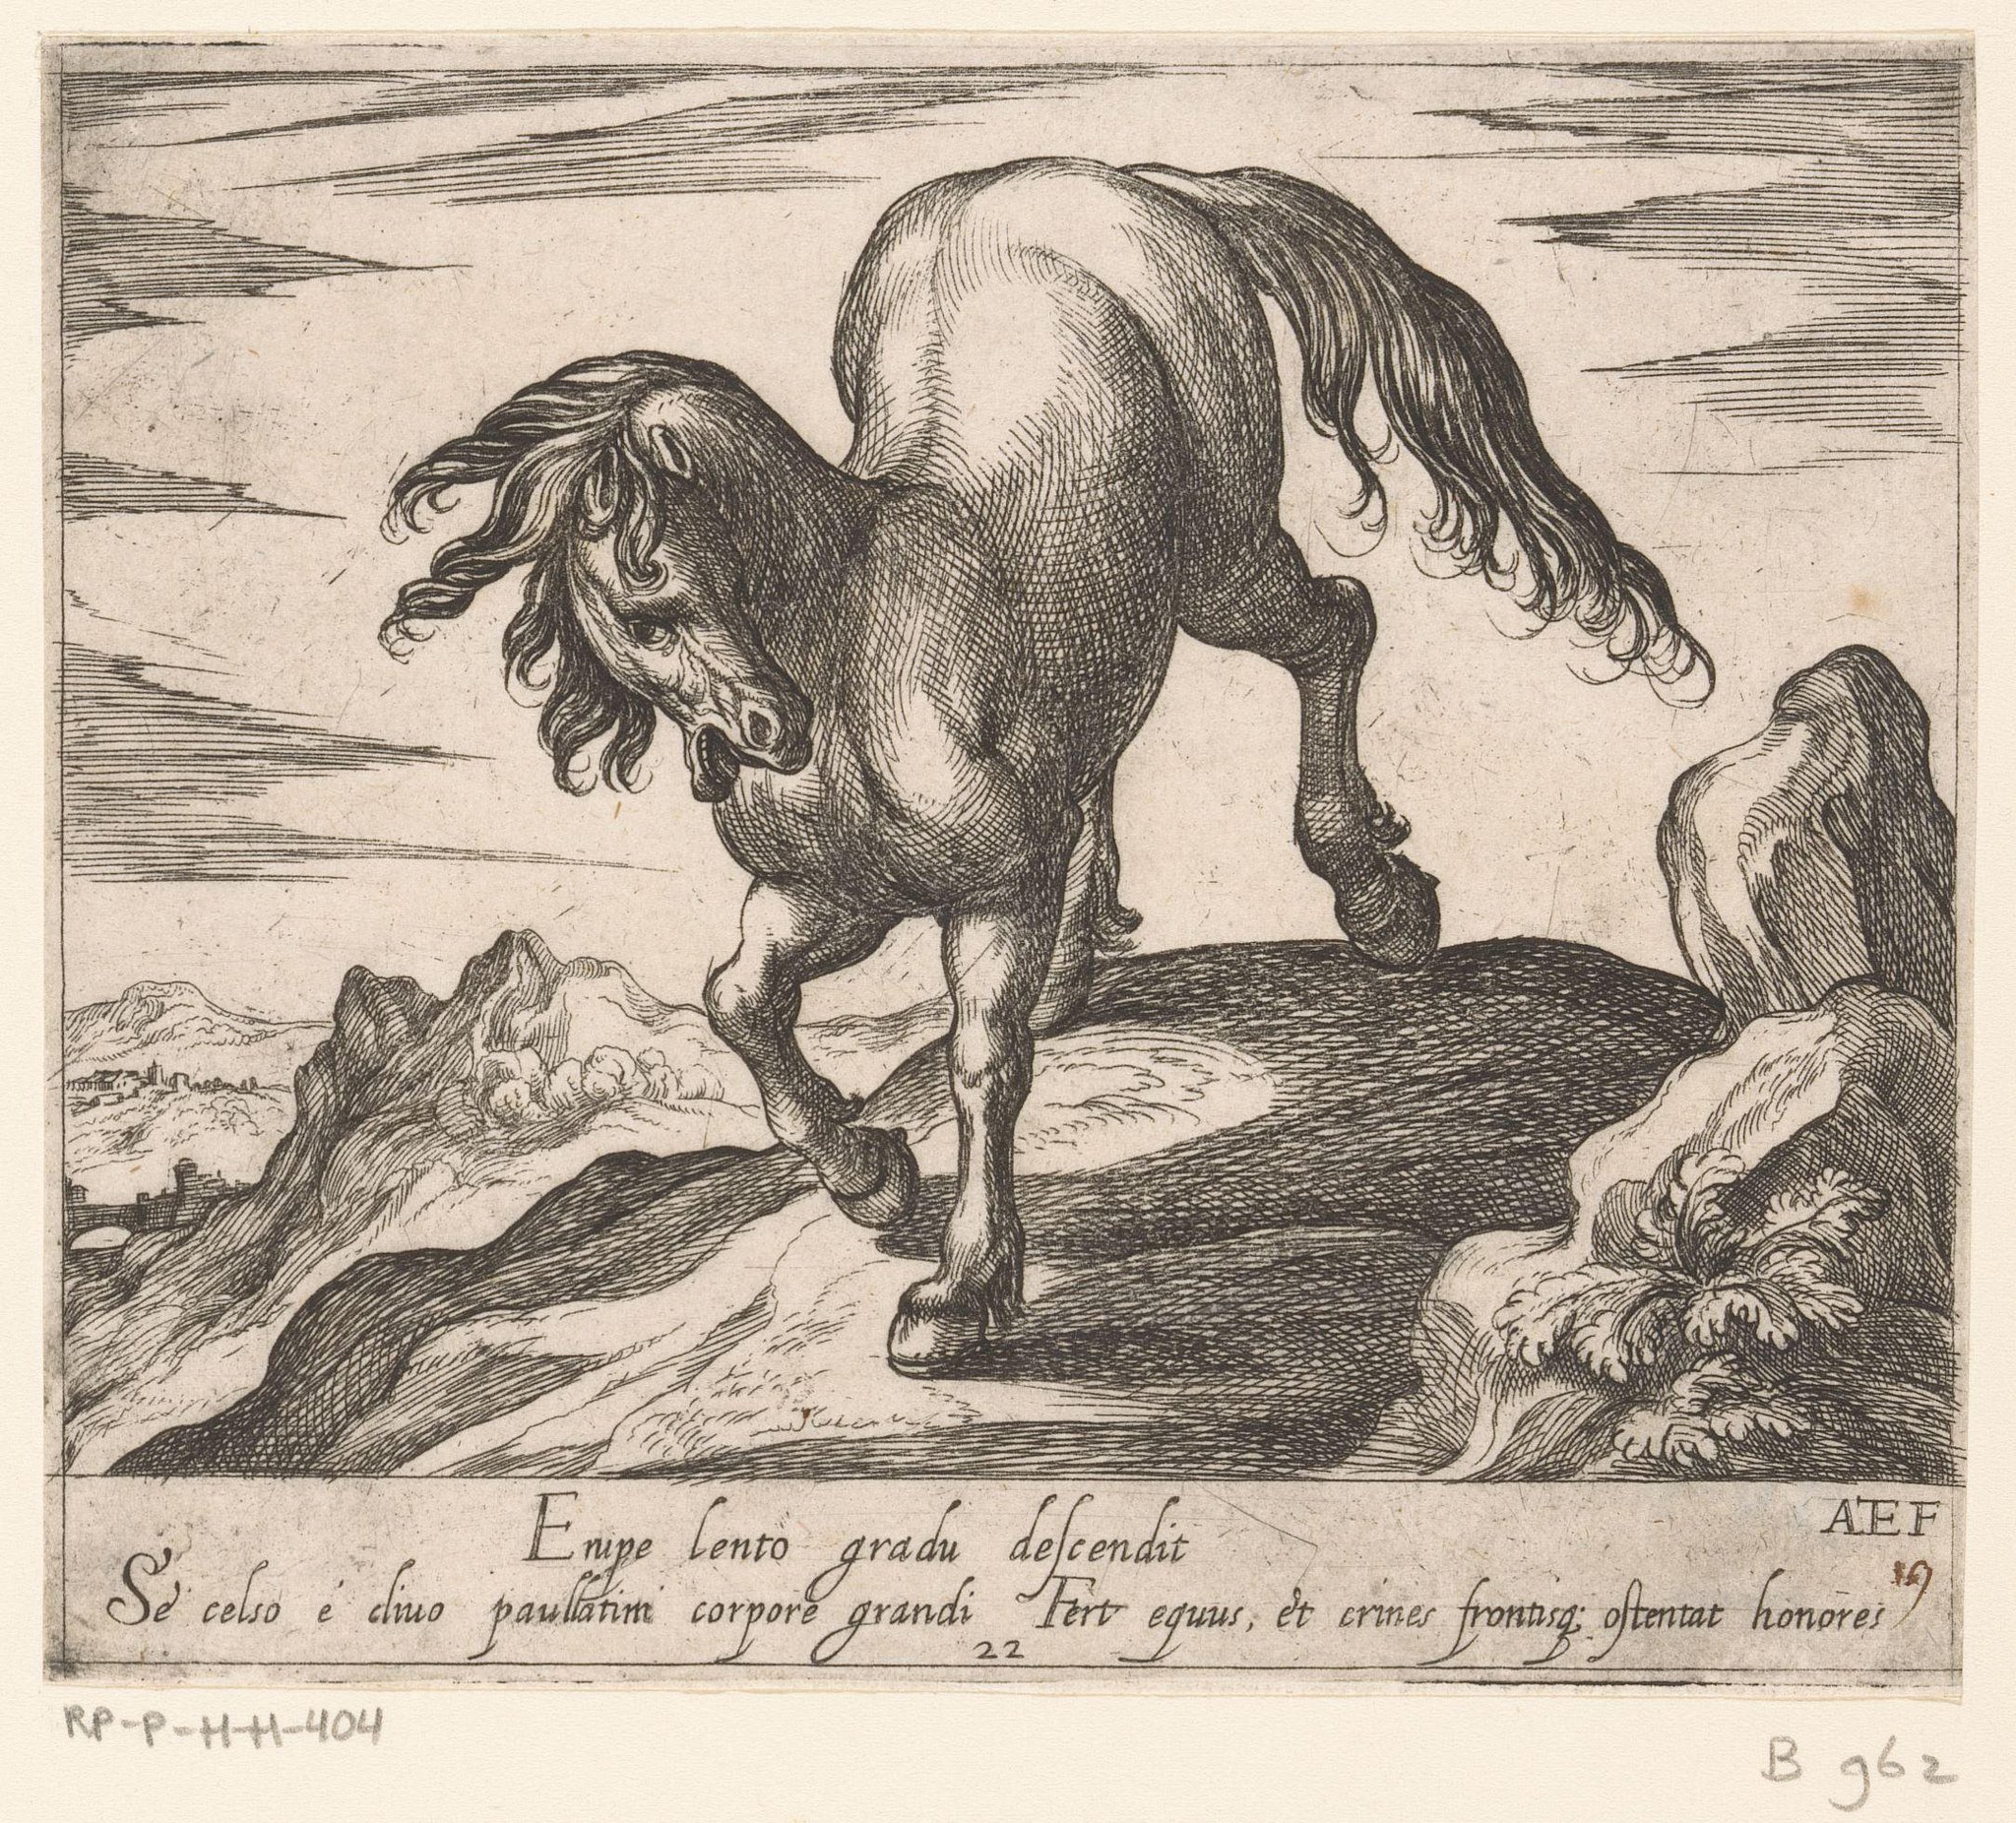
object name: print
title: His ducibus princeps celebraberis ore viroru illa homines beat haec sideribusq locat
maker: antonio tempesta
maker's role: draughtsman, painter, print maker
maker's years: 1555-1630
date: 1590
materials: paper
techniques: etching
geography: italy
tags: horse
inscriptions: number: ‘19’, collector's mark: ‘Hinloopen’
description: Deze prent maakt deel uit van een reeks van 28 prenten van paarden (+ titelprent en opdracht).